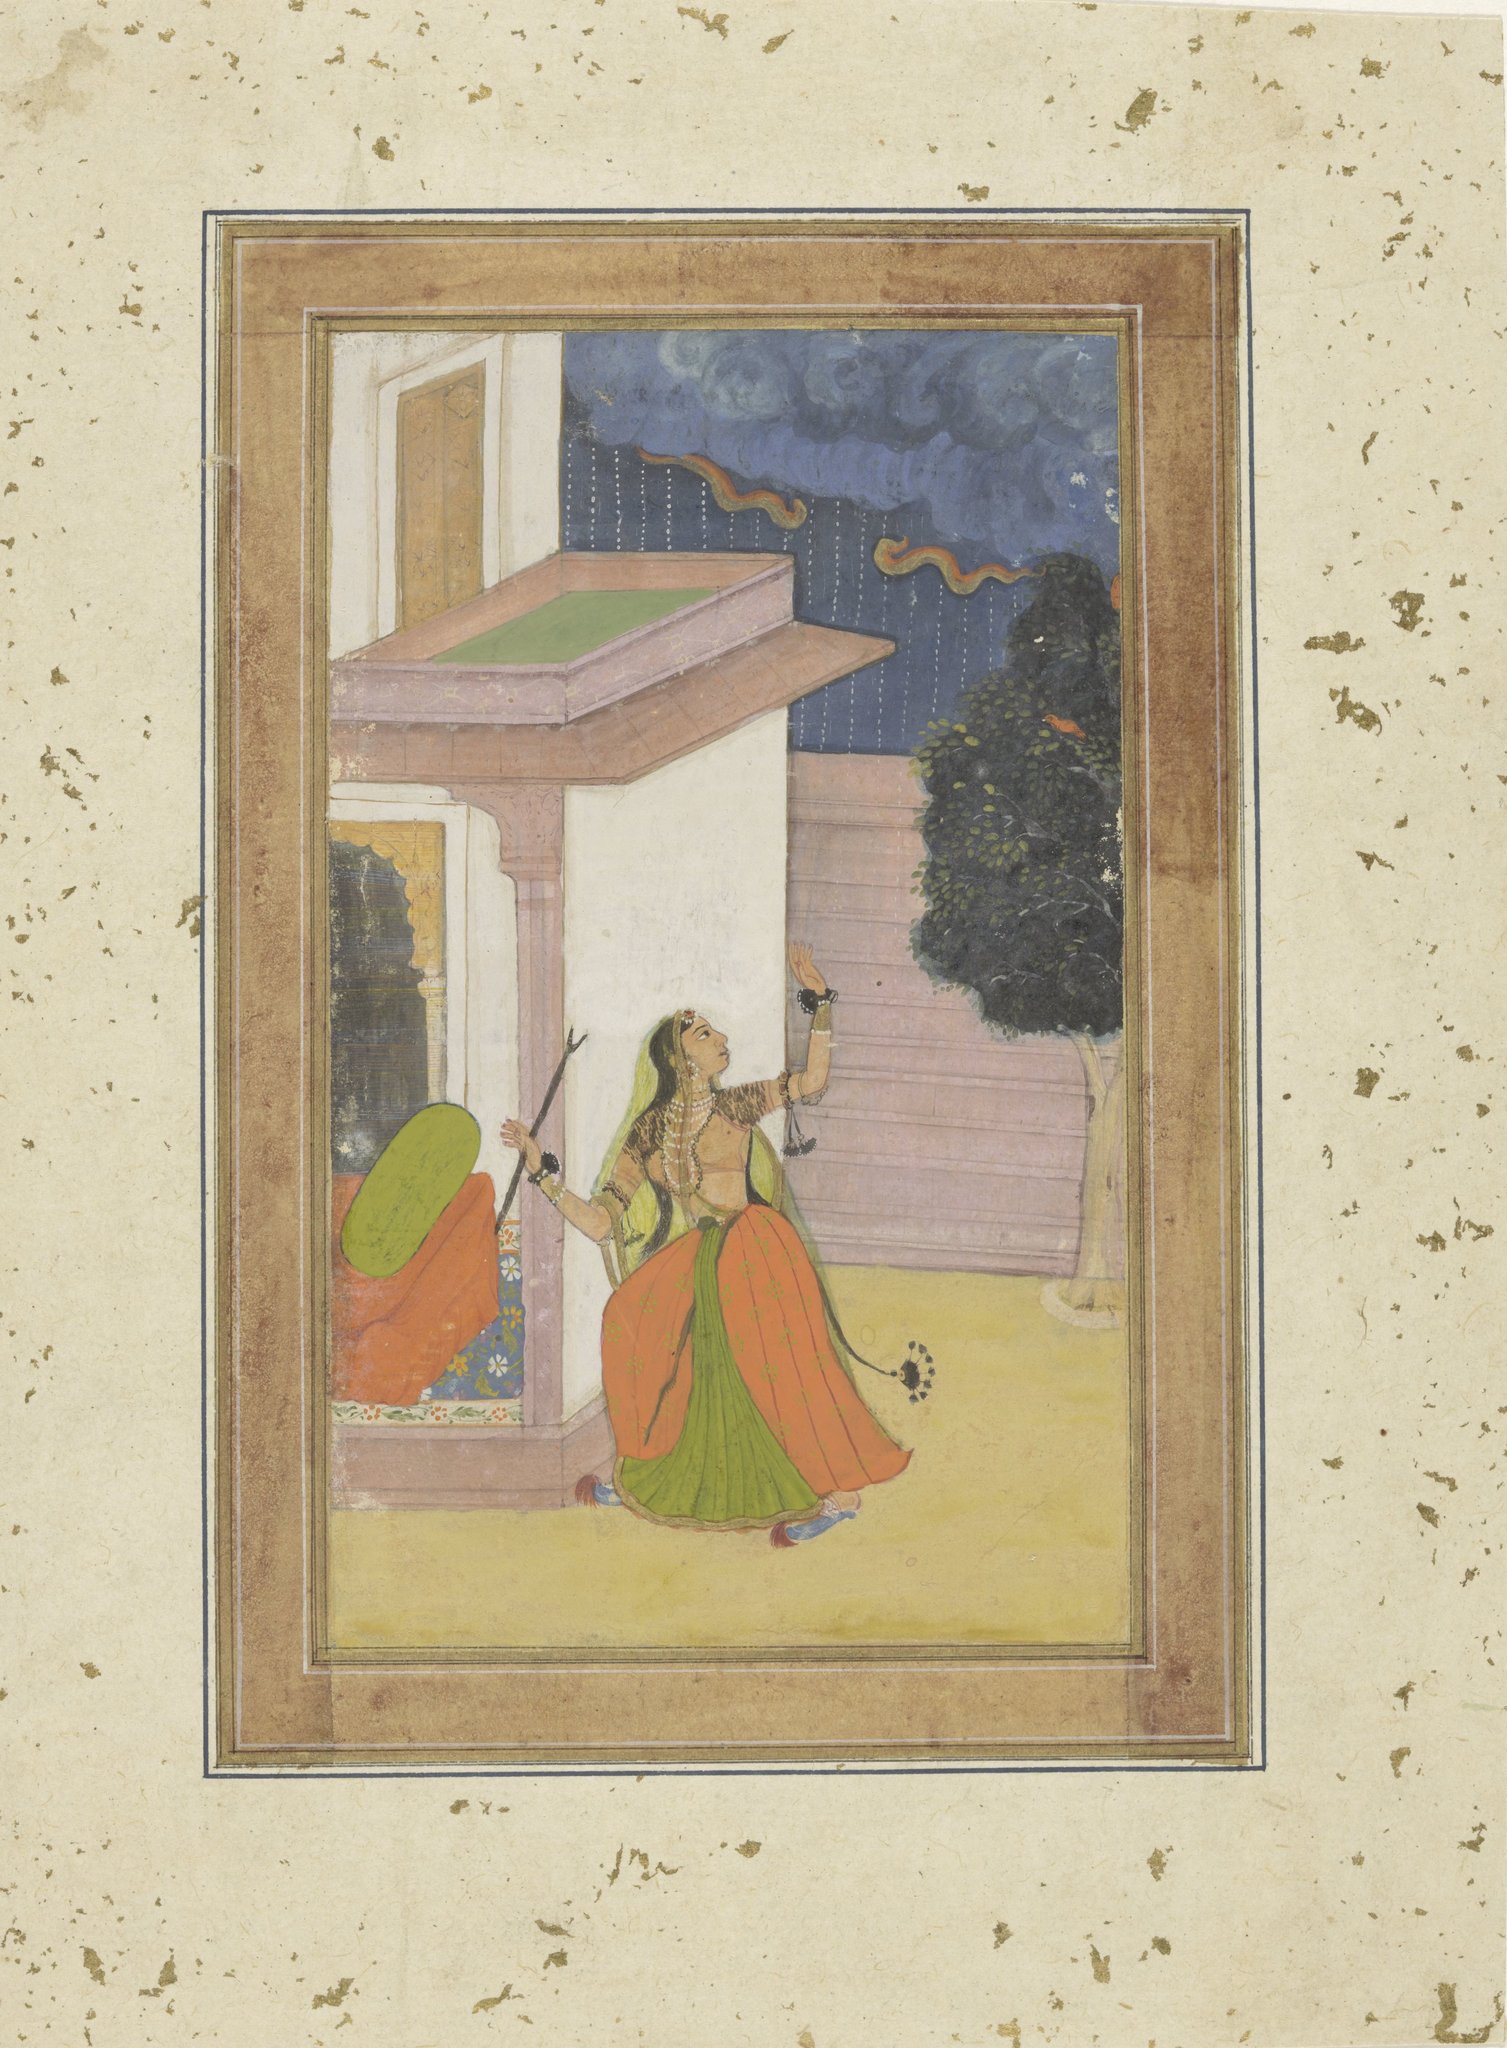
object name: indian miniature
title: Madhu Madhavi ragini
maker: Anonymous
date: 1670-1690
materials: paper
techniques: brush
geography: bikaner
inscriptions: inscription: ‘.’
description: Een vrouw voor een paleis vlucht naar binnen voor het onweer buiten. De voorstelling is omlijst door een bruine rand, afgezet met goud in zwarte kaderlijnen en een brede bladrand bespikkeld met goud.